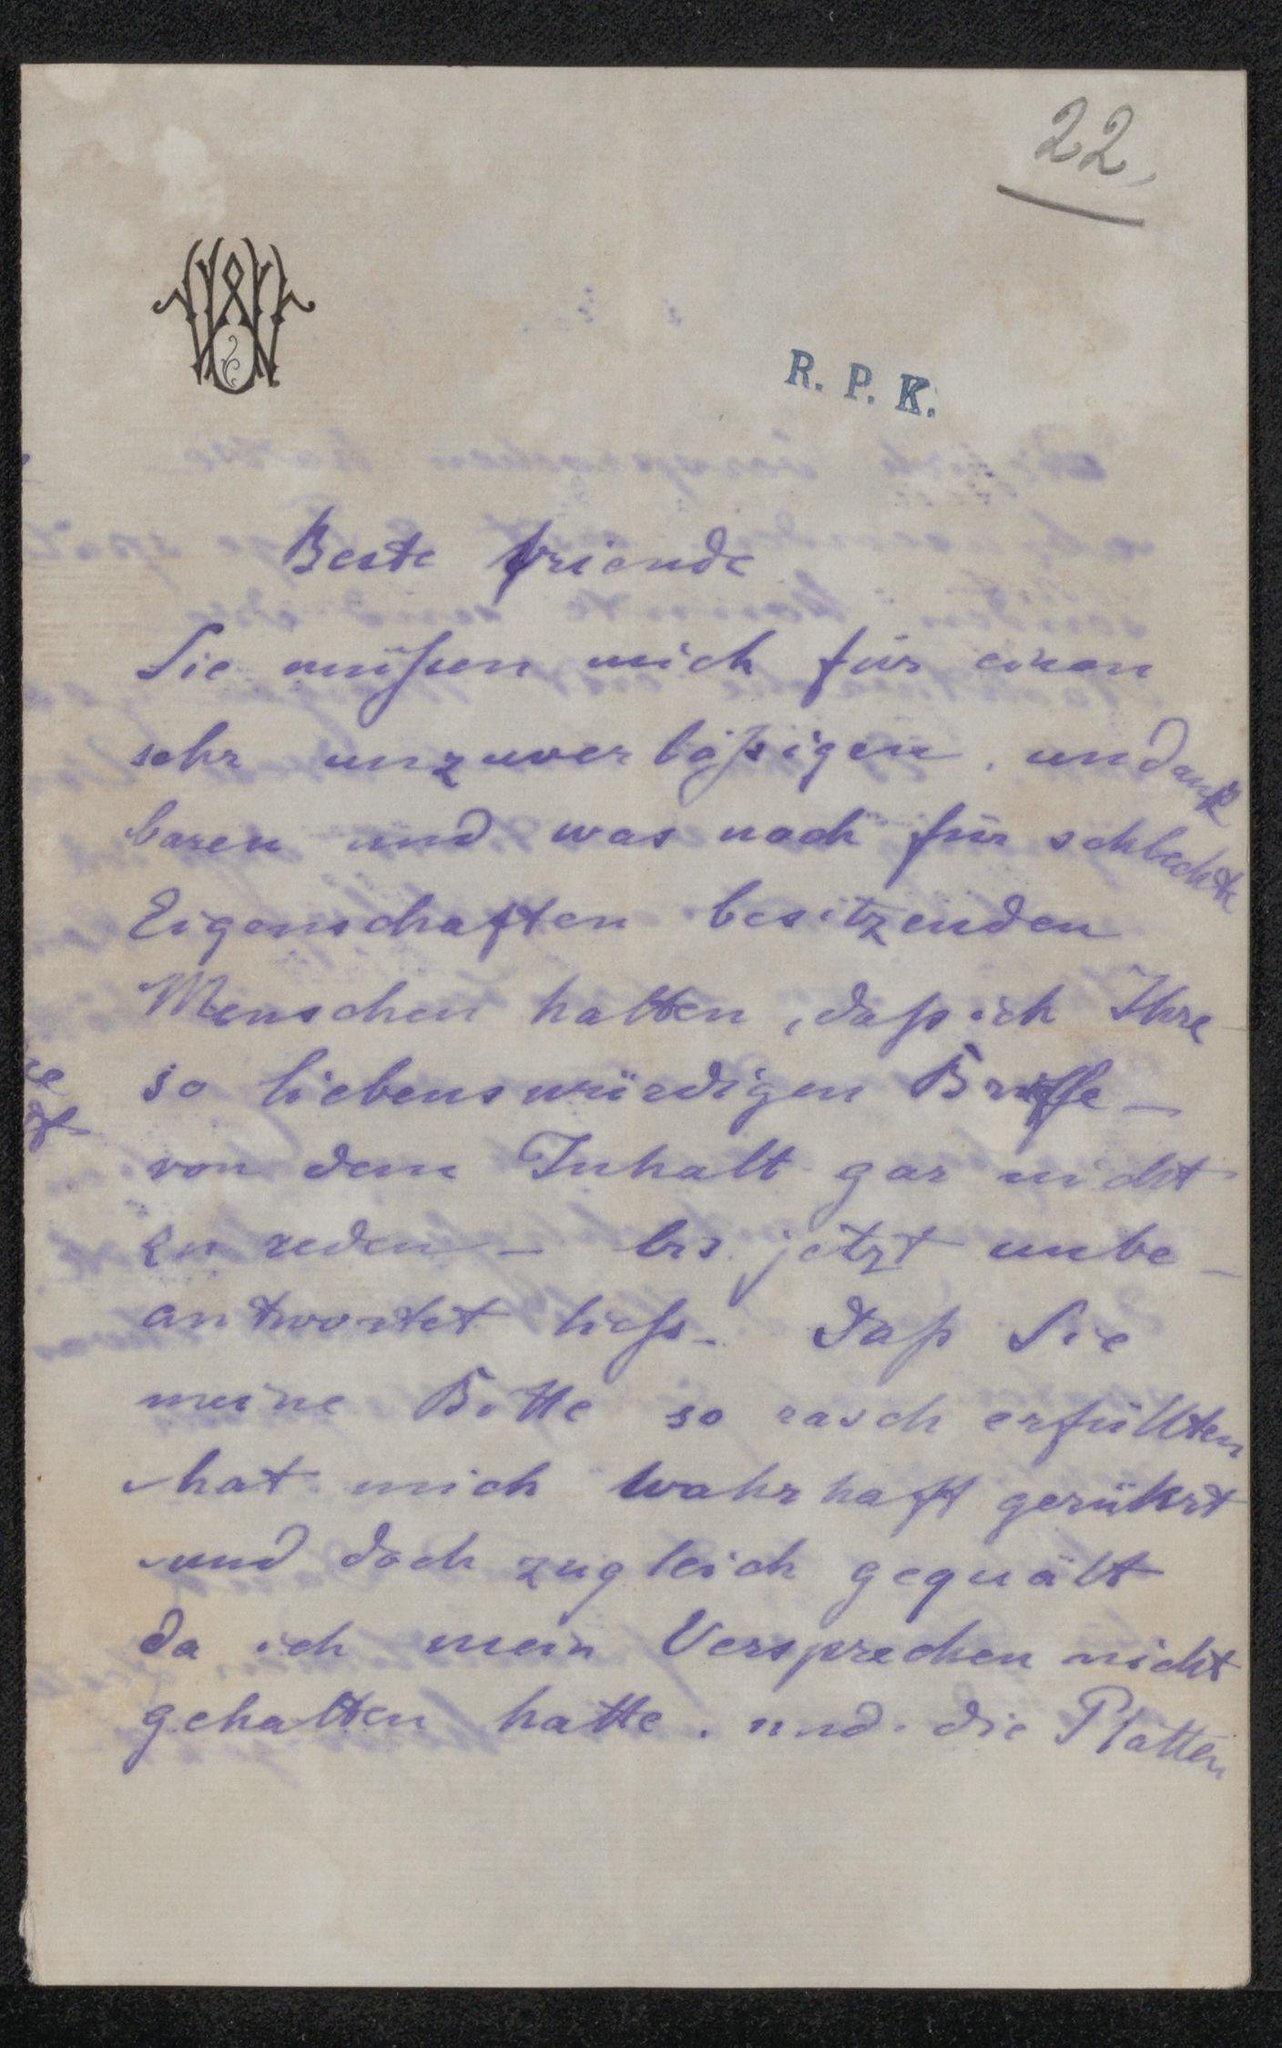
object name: letter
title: Brief aan Frans Buffa en Zonen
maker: william unger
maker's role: draughtsman, painter, print maker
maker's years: 1837-1932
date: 1877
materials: ink, paper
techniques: pen, printing, writing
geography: vienna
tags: haarlem, bartholomeus van der helst, publisher, leiden, amsterdam, rembrandt van rijn, passions, emotions, affections, the graphic arts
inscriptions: collector's mark: Lugt 2233